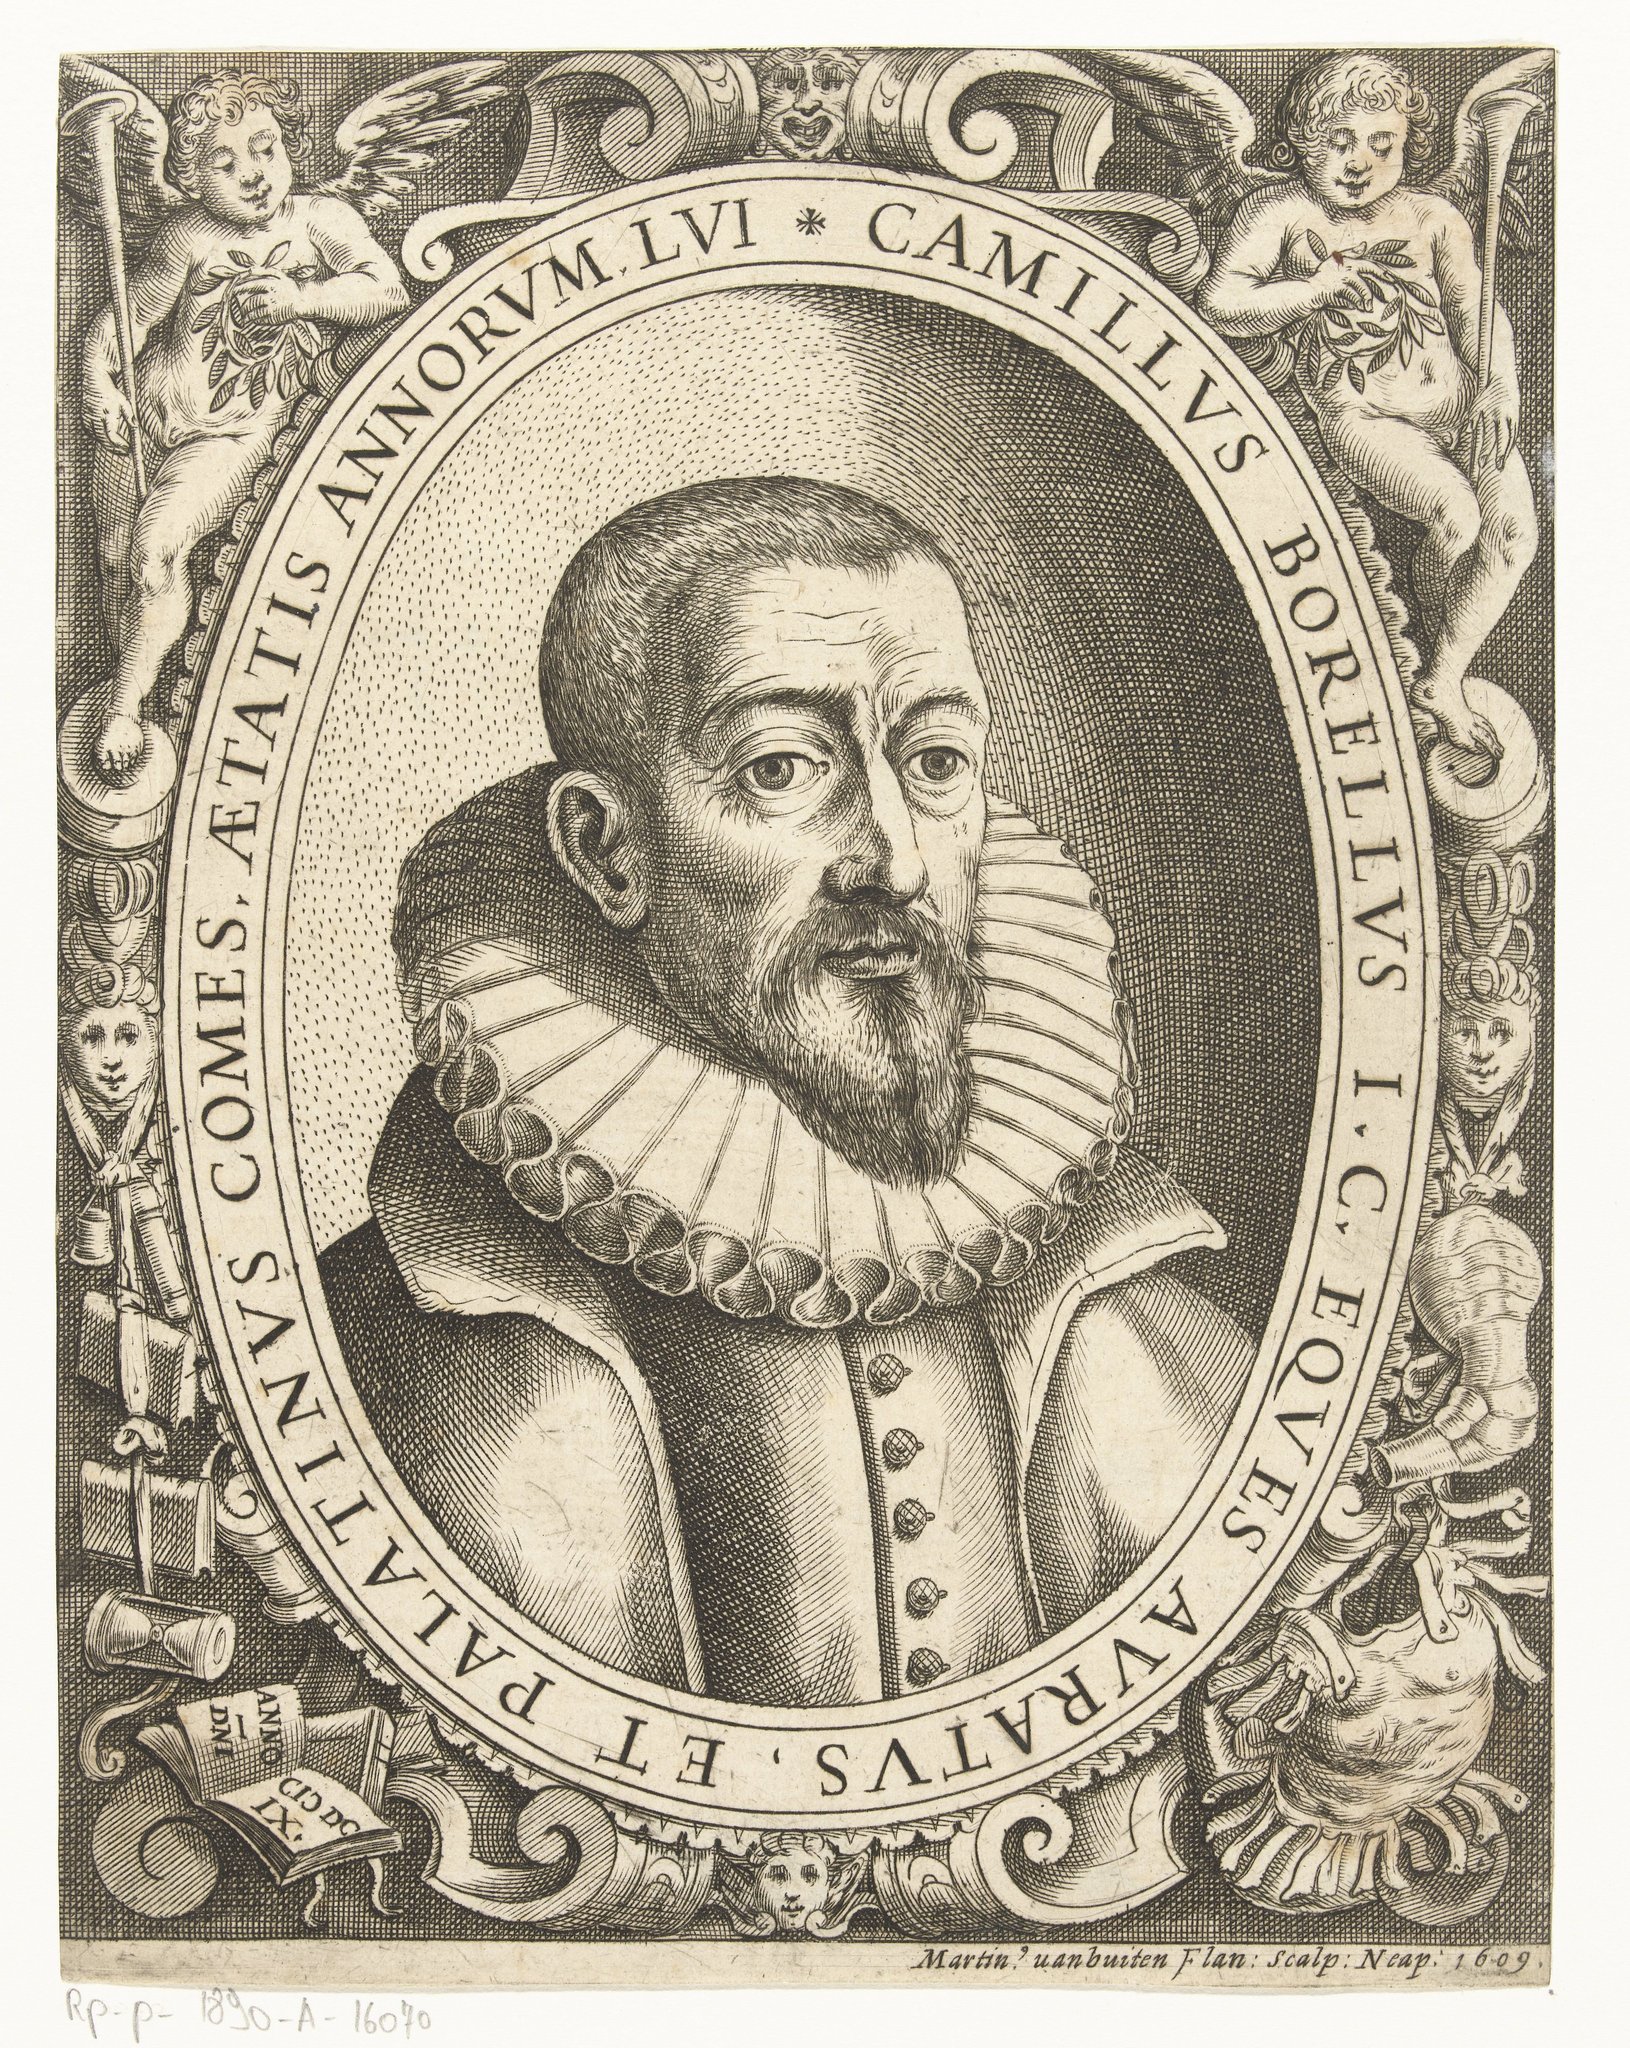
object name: print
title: Portret van Camillus Berellius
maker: martin van buyten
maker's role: print maker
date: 1609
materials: paper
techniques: engraving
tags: cupids: 'amores', 'amoretti', 'putti'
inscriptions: number: ‘4116’, collector's mark: Lugt 2228, number: ‘Nr. 387’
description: Portret in ovale lijst van Camillus Berellius, een zeventiende-eeuwse schrijver. Buste naar rechts. Rondom het portret twee putti.